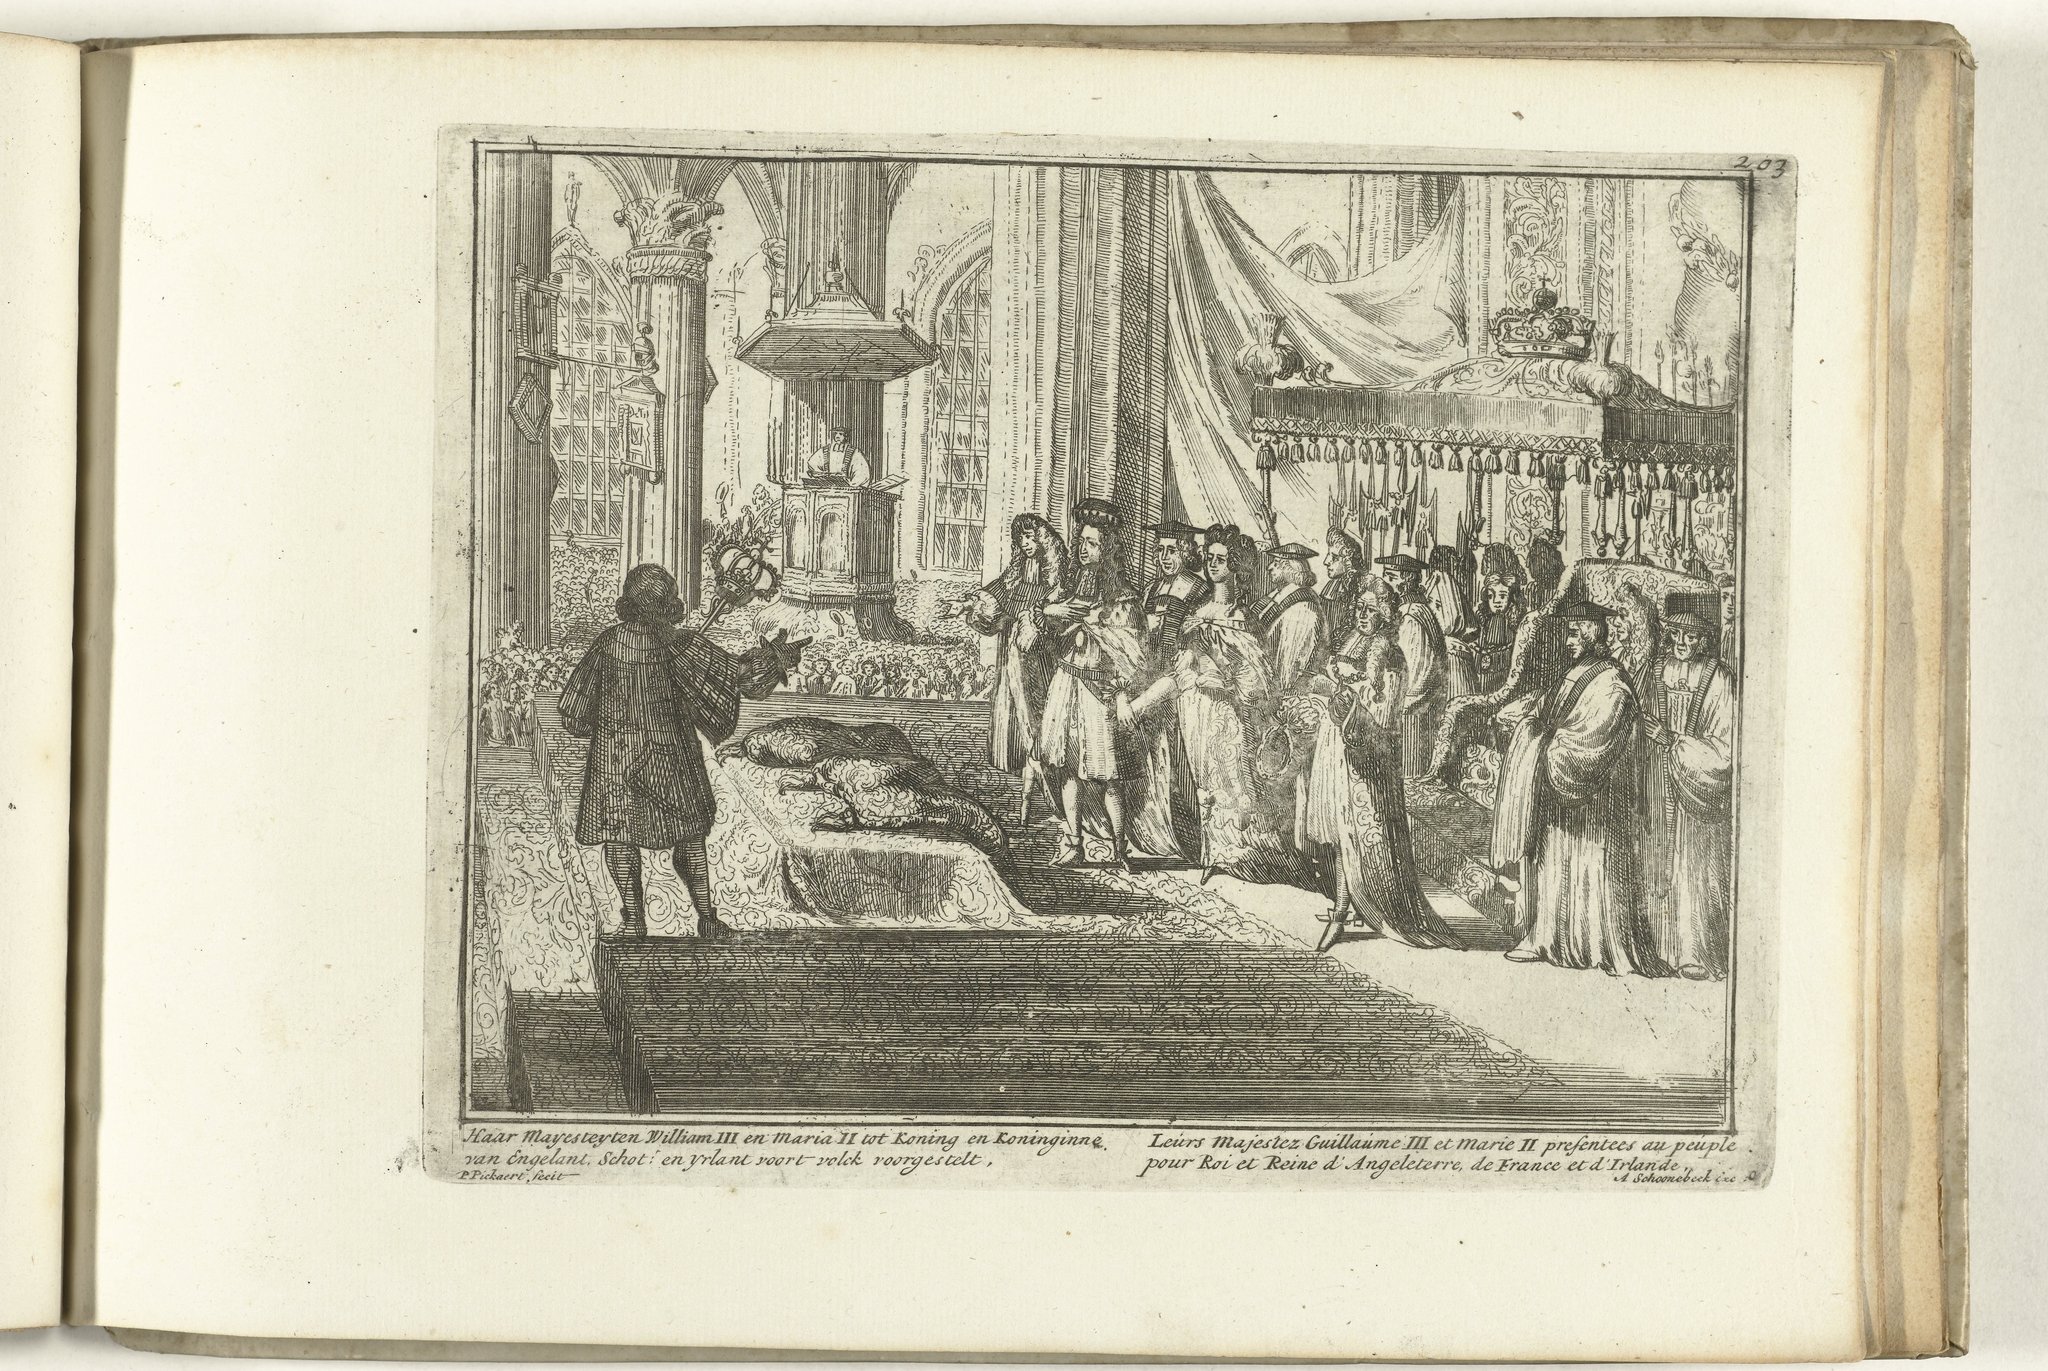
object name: print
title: Engelants schoutoneel verbeeldende de Glorieuse overtogt met het kroonen van William III en Maria II tot Koning en Koningin van groot Brittany en Vrankryk en Yrlant, etc. II Deel.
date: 1689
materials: paper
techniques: etching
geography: amsterdam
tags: william iii (prince of orange and king of england, scotland, and ireland), london, maria ii stuart (koningin van engeland, schotland en ierland), coronation of a ruler, westminster abbey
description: Het voorstellen aan het verzamelde volk in de Westminster Abbey van prins Willem III en prinses Maria als de nieuwe koning en koningin van Engeland, 21 april 1689. Genummerd rechtsboven: 203. Plaat O in de serie 'Engelants schouwtoneel' over de Glorious Revolution 1688-1689 (tweede deel). Met onderschriften in het Nederlands en Frans.